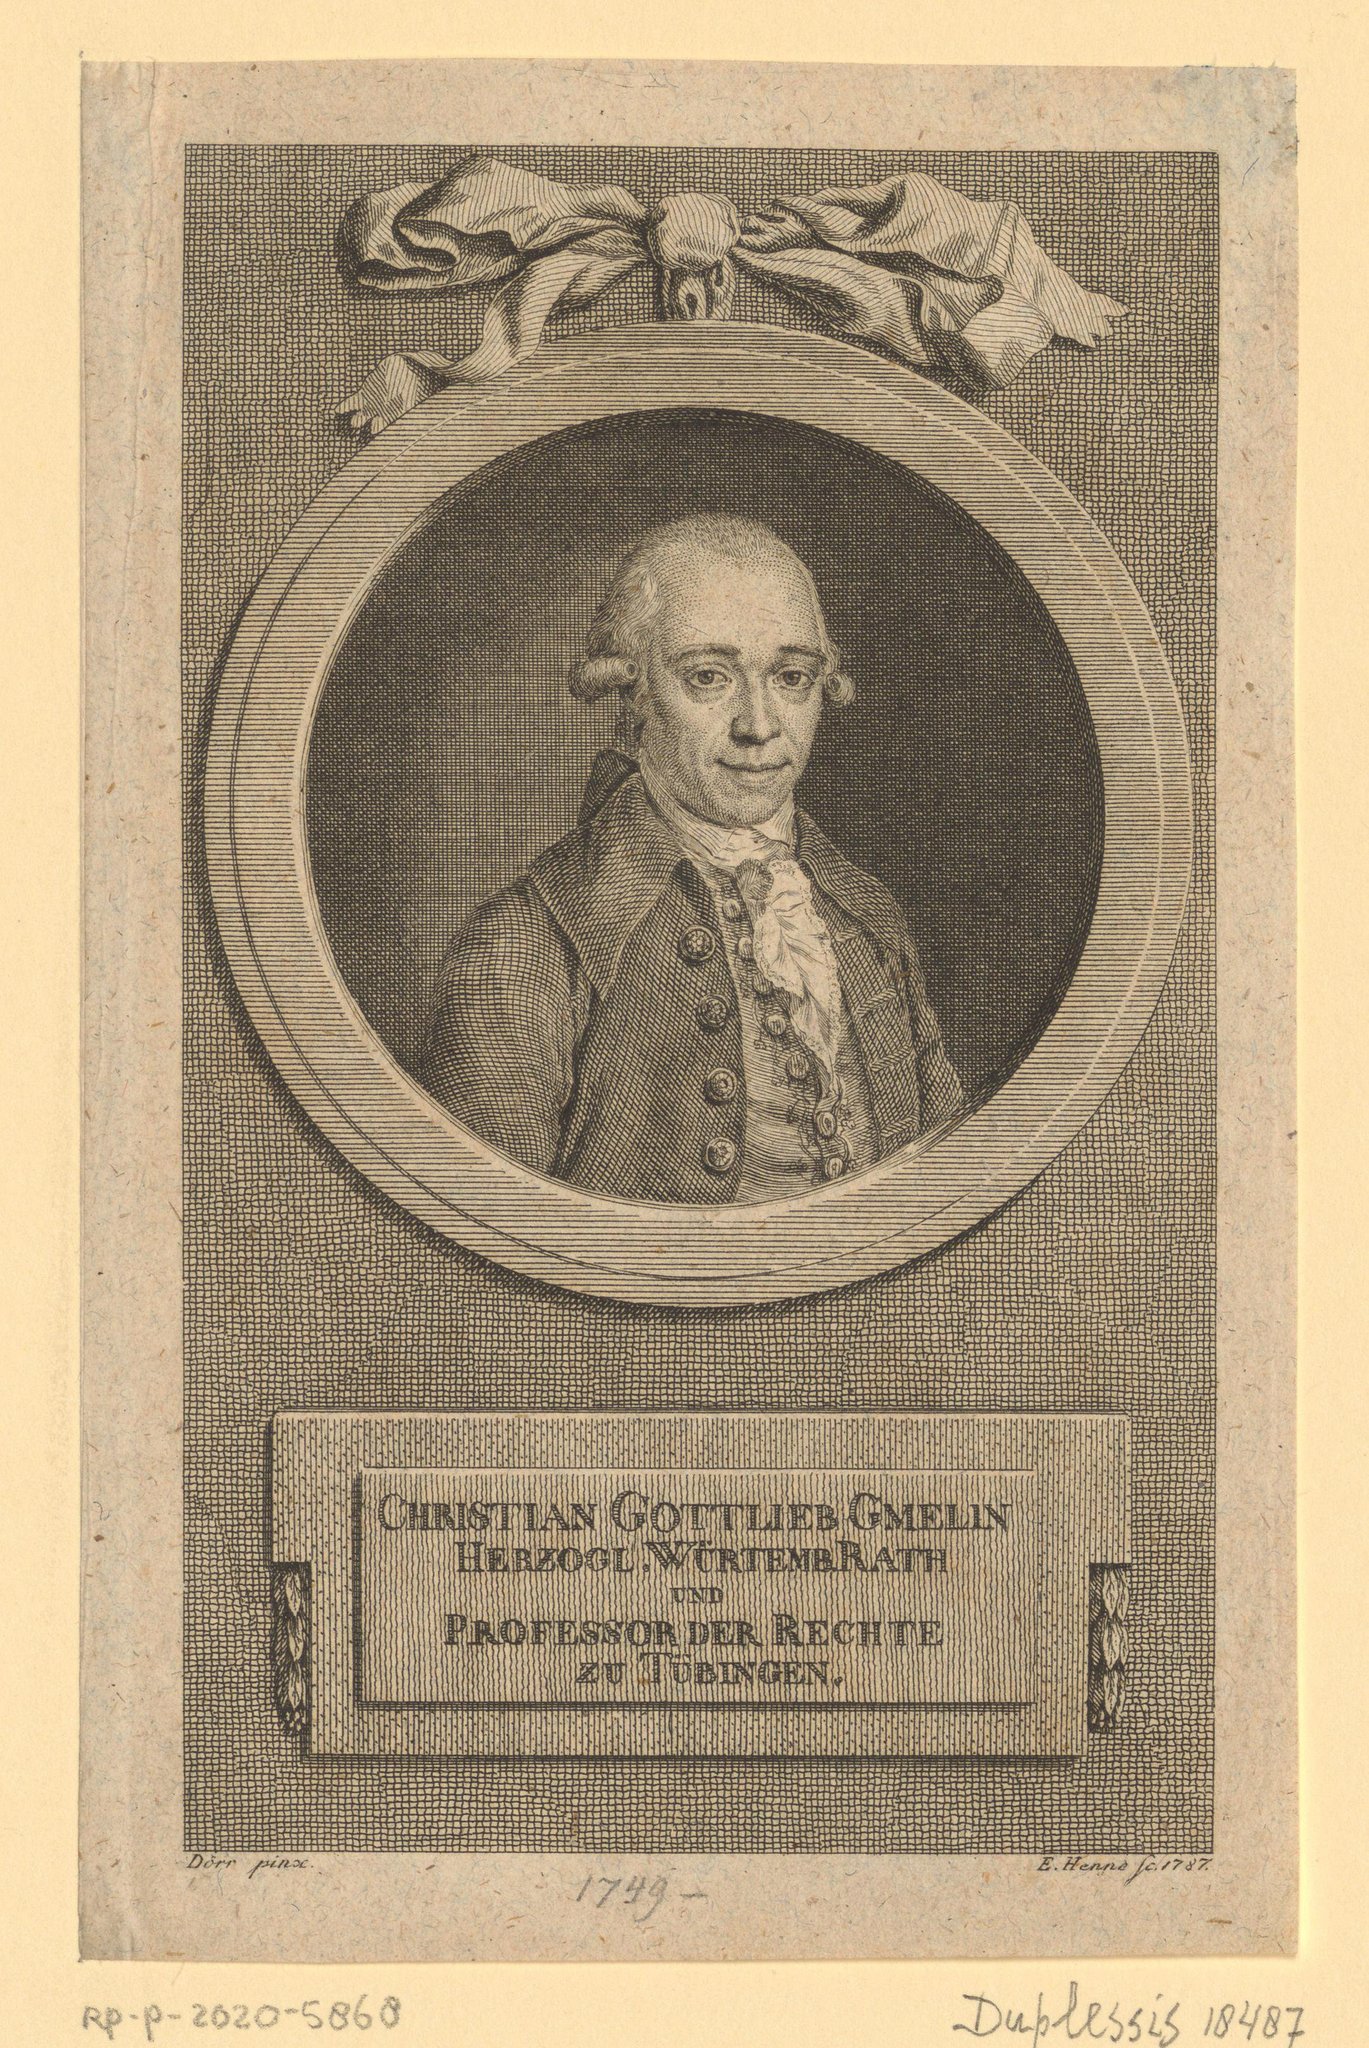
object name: print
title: Portret van Christian Gottlieb von Gmelin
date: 1769-1828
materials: paper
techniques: engraving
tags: historical persons, lawyer, attorney at law, professor